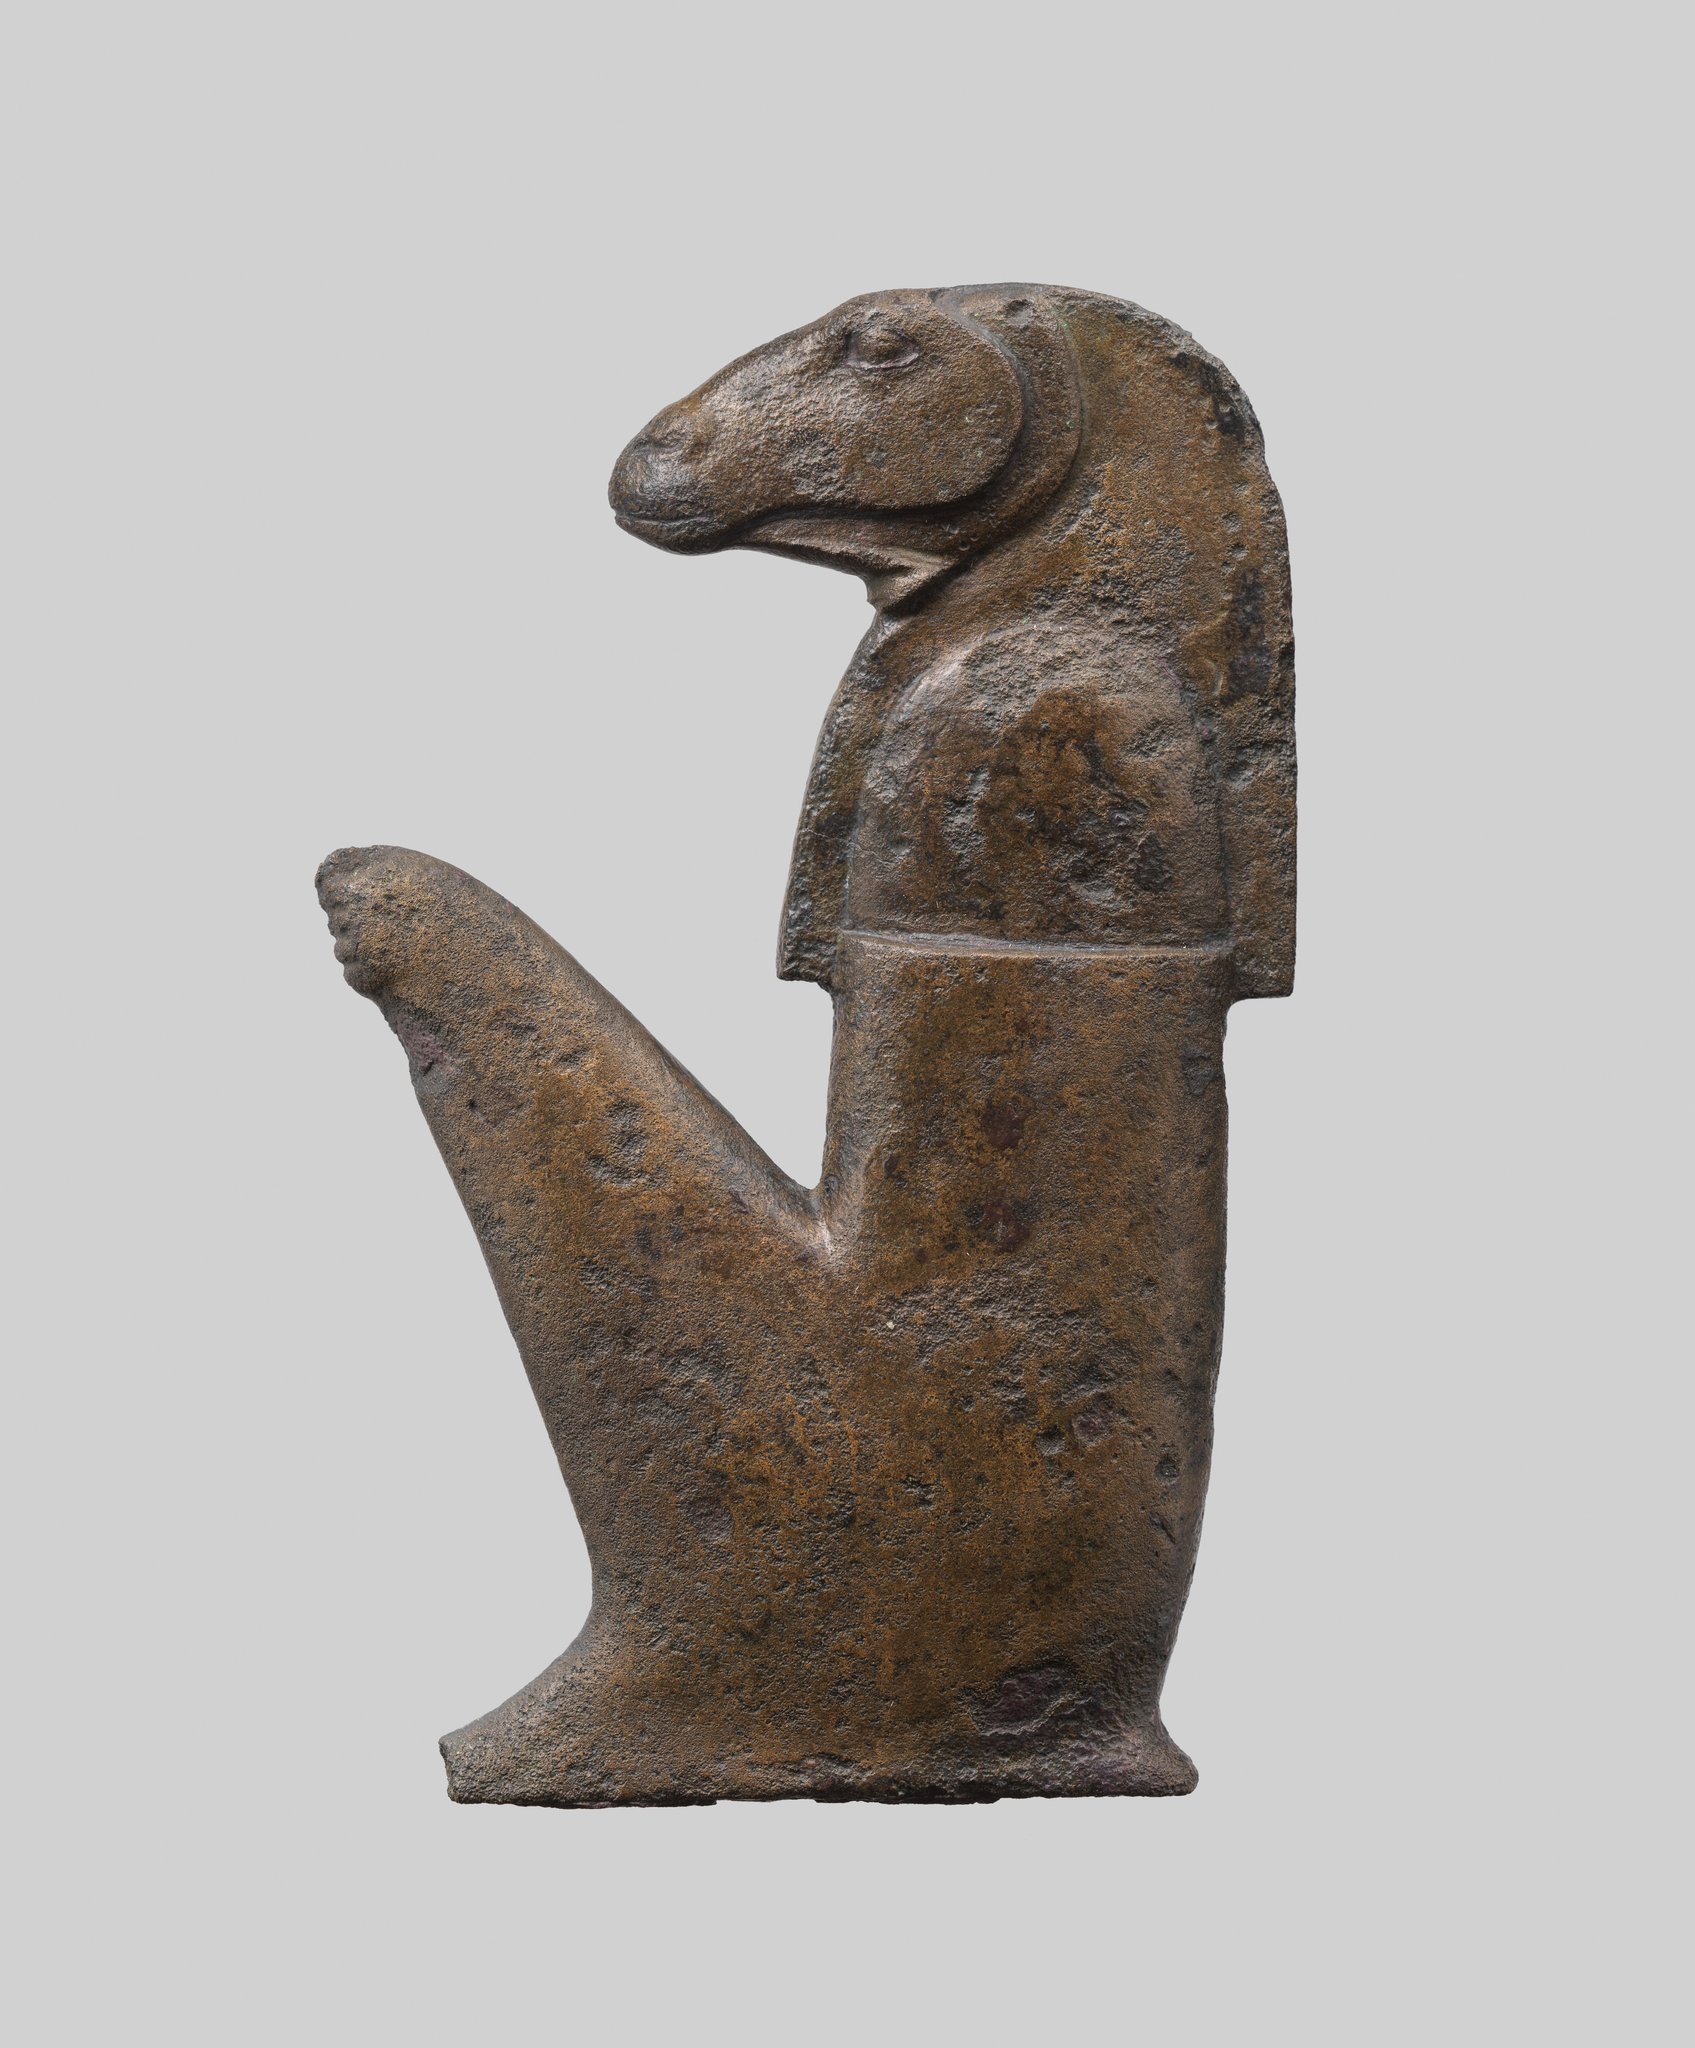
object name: inlay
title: Furniture attachment with a sitting ram-headed deity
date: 733-343 BCE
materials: bronze, copper alloy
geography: egypt